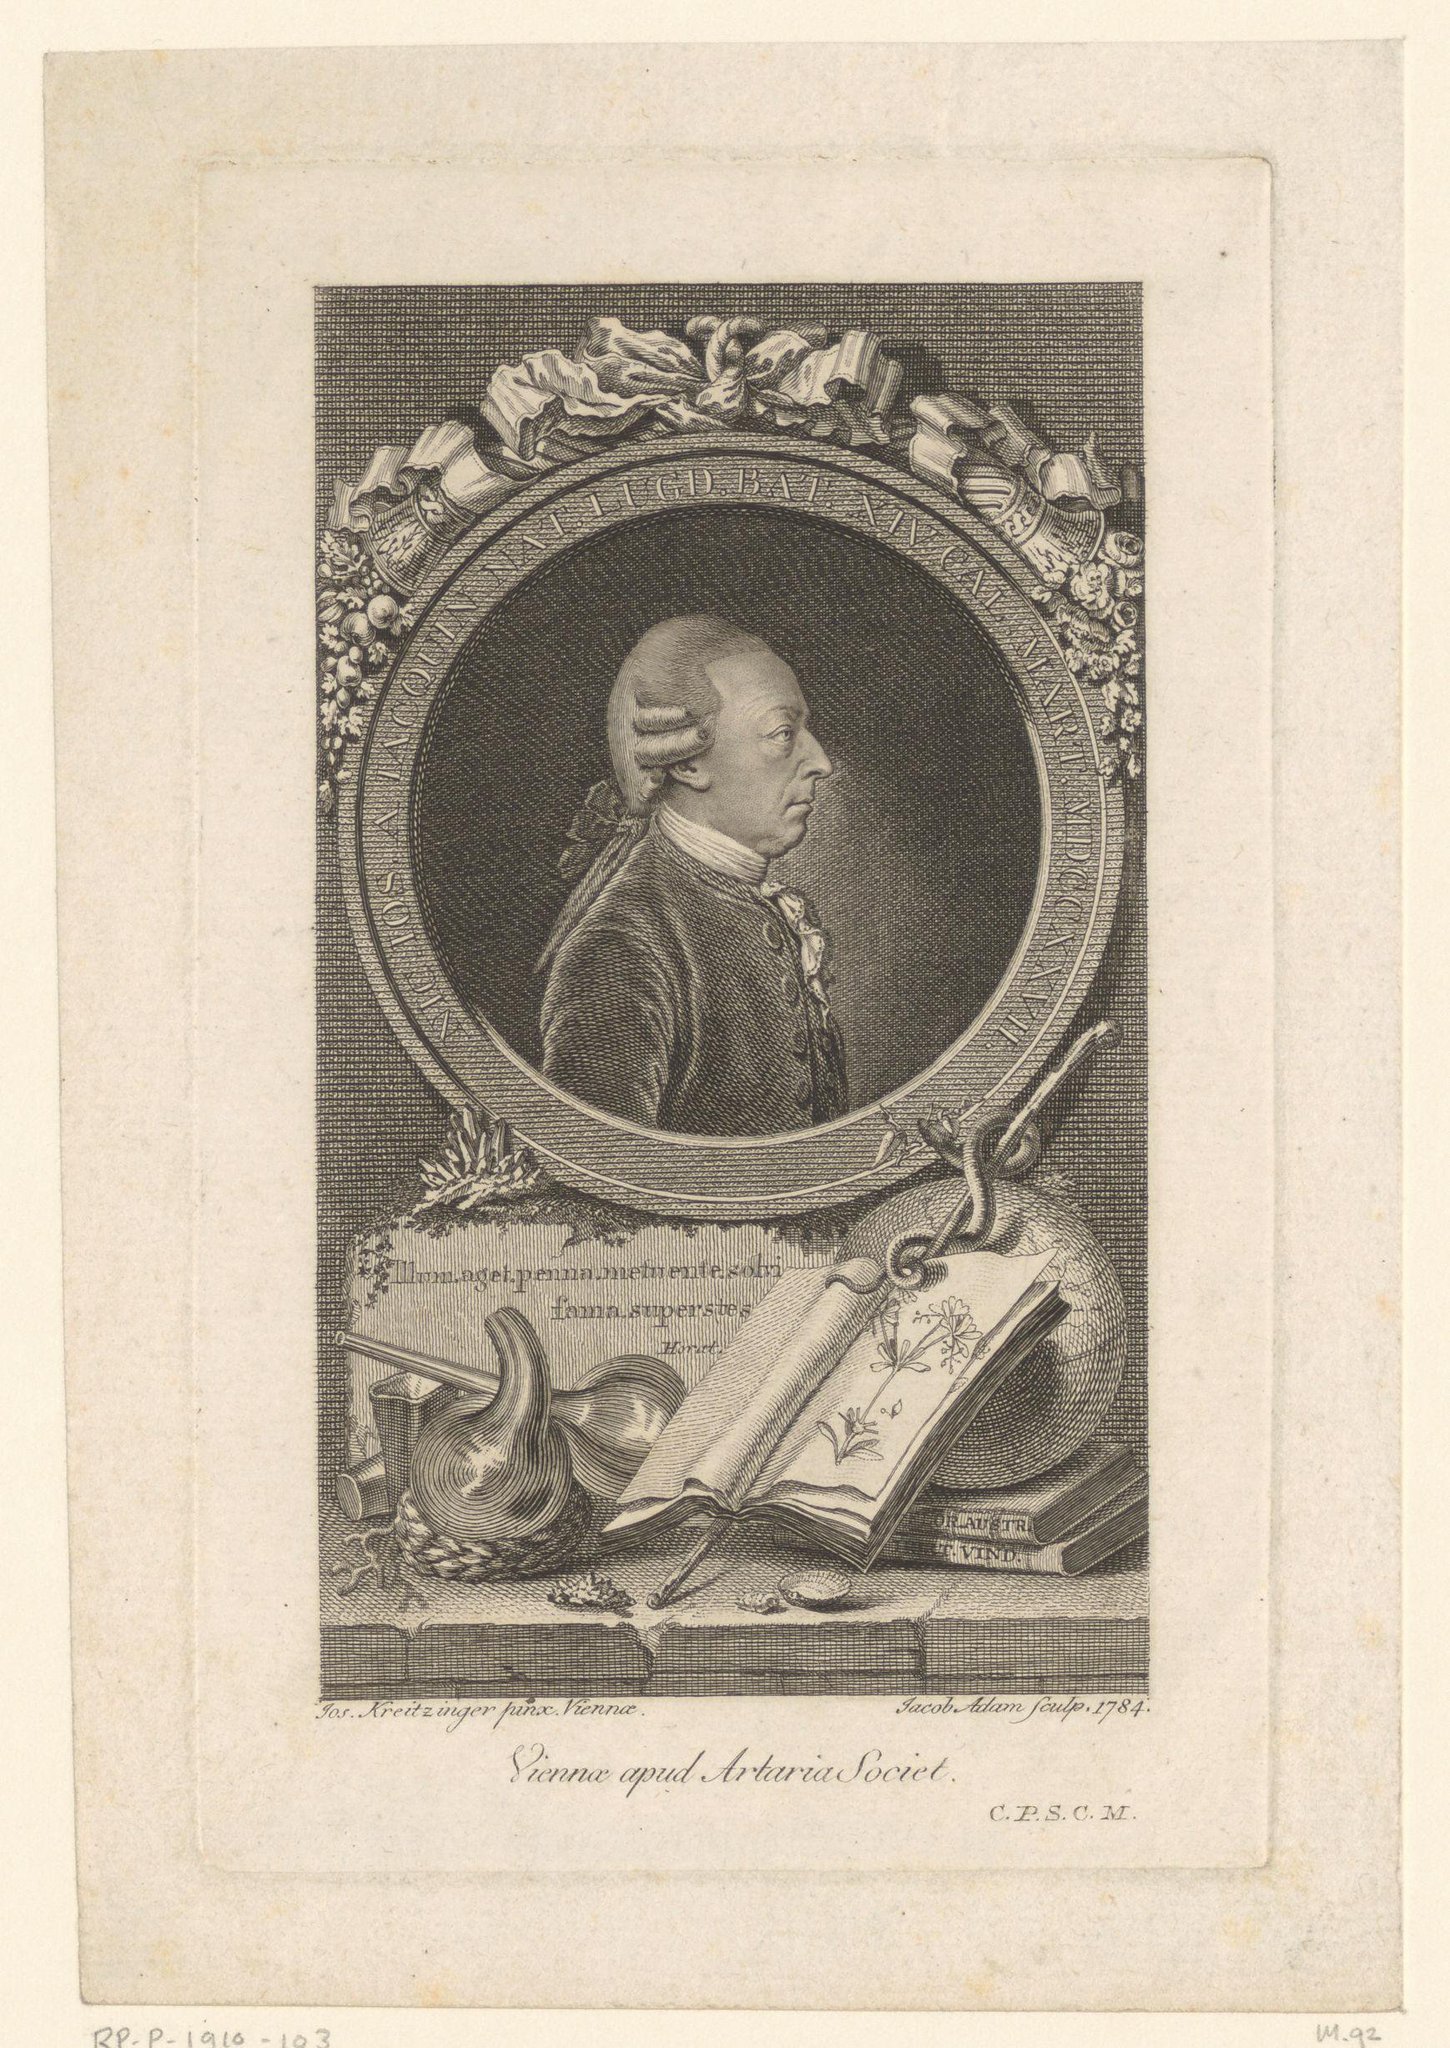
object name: print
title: Portret van Nikolaus Joseph von Jacquin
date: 1784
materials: paper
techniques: etching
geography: vienna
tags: leiden, vienna, historical persons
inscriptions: collector's mark: Lugt 2228